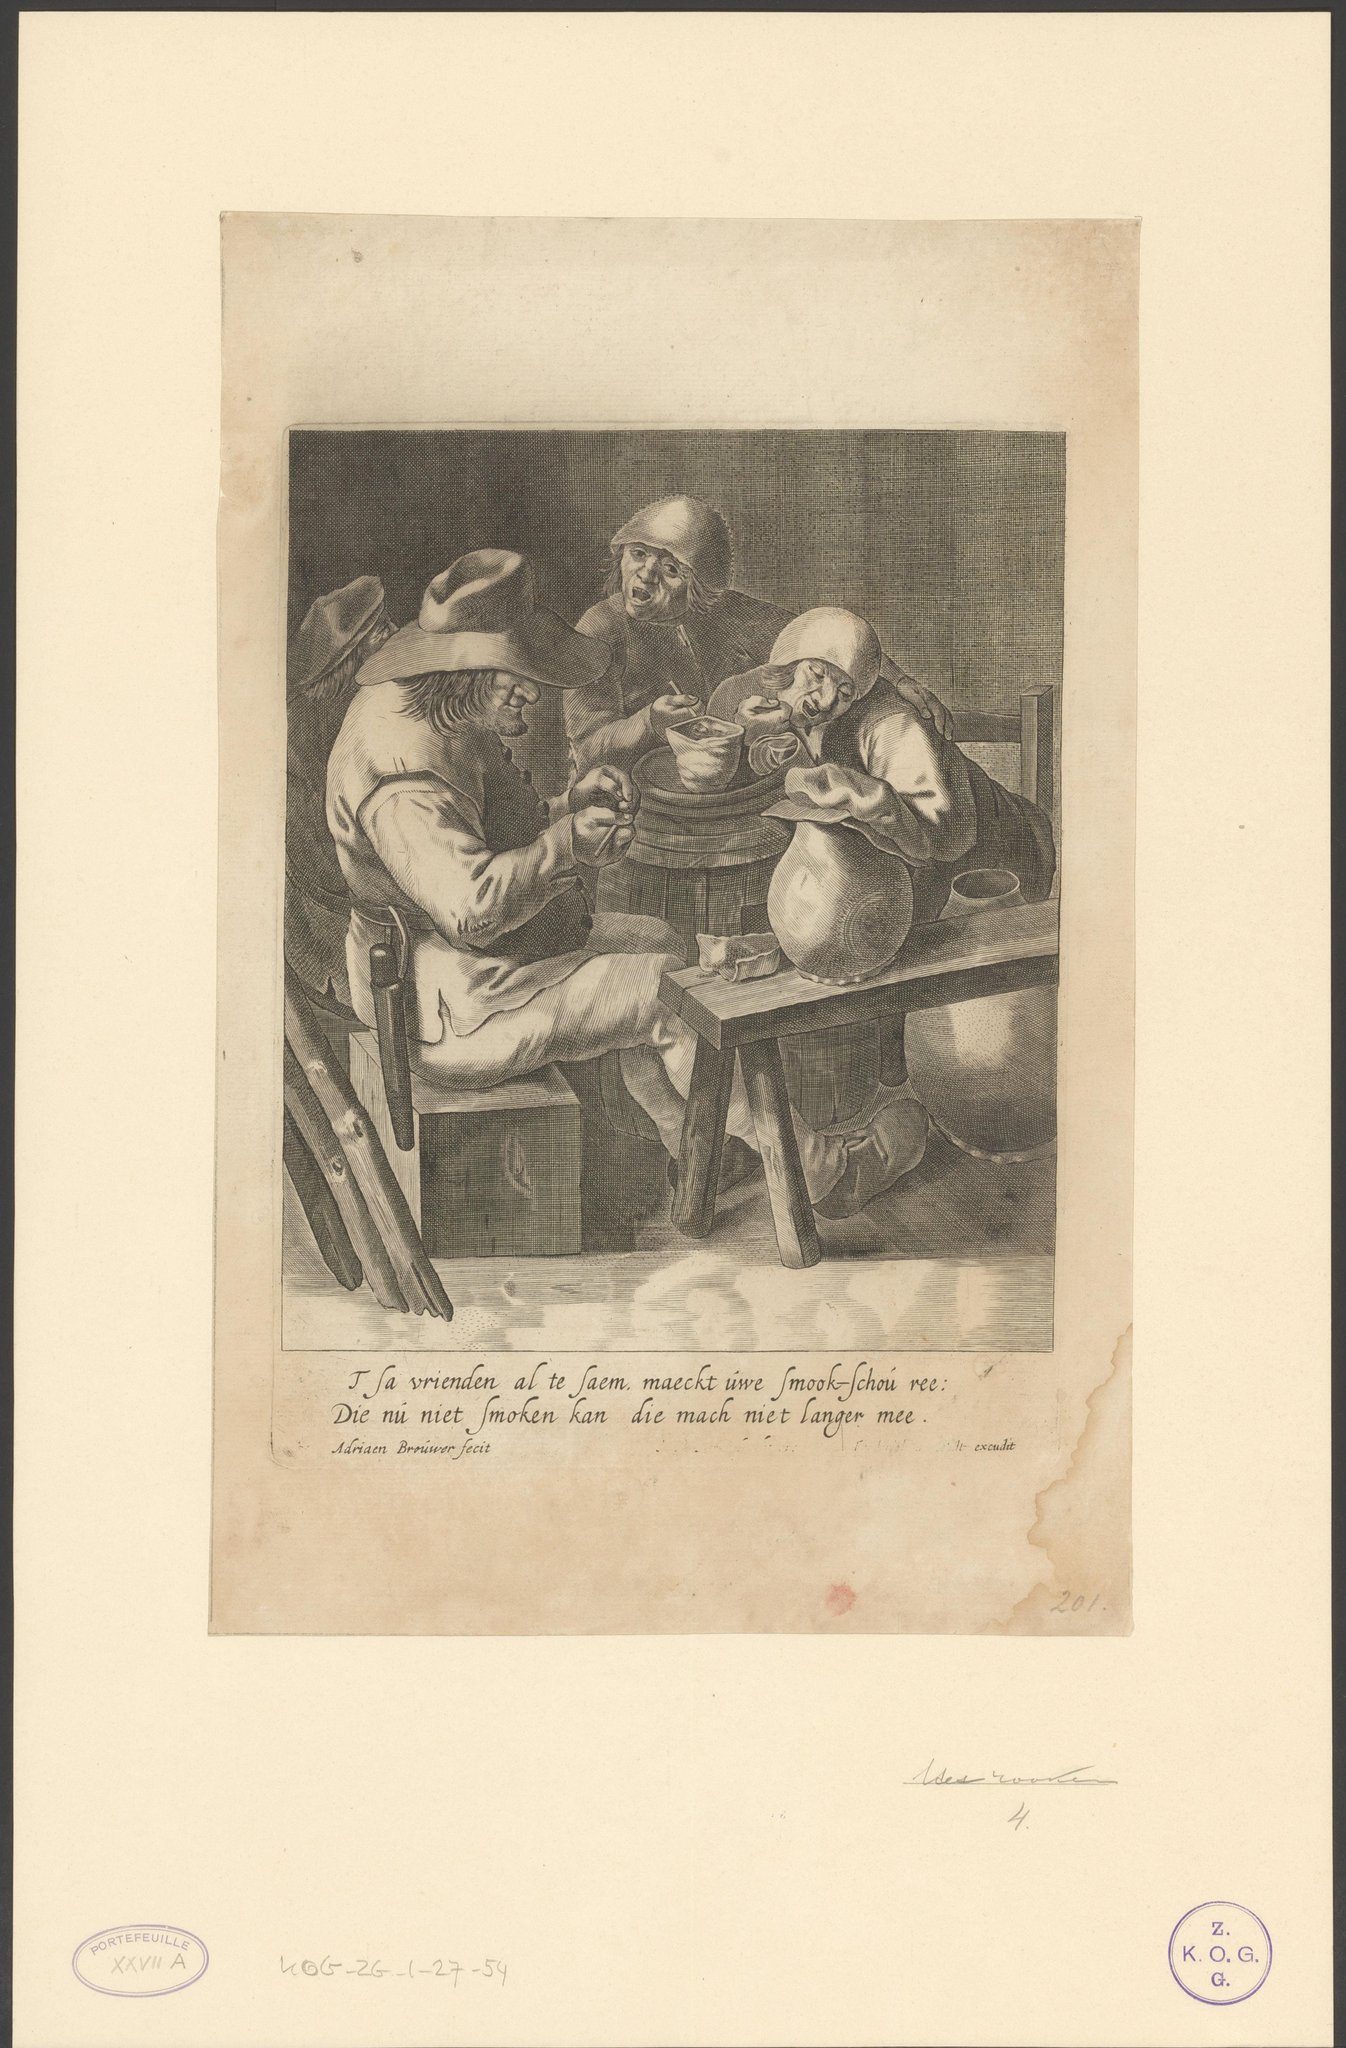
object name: print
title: Vier rokende boeren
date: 1675-1750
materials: paper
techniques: engraving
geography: netherlands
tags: inn, coffee-house, public house, etc., pipe ~ tobacco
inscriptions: collector's mark, collector's mark: Lugt 1641